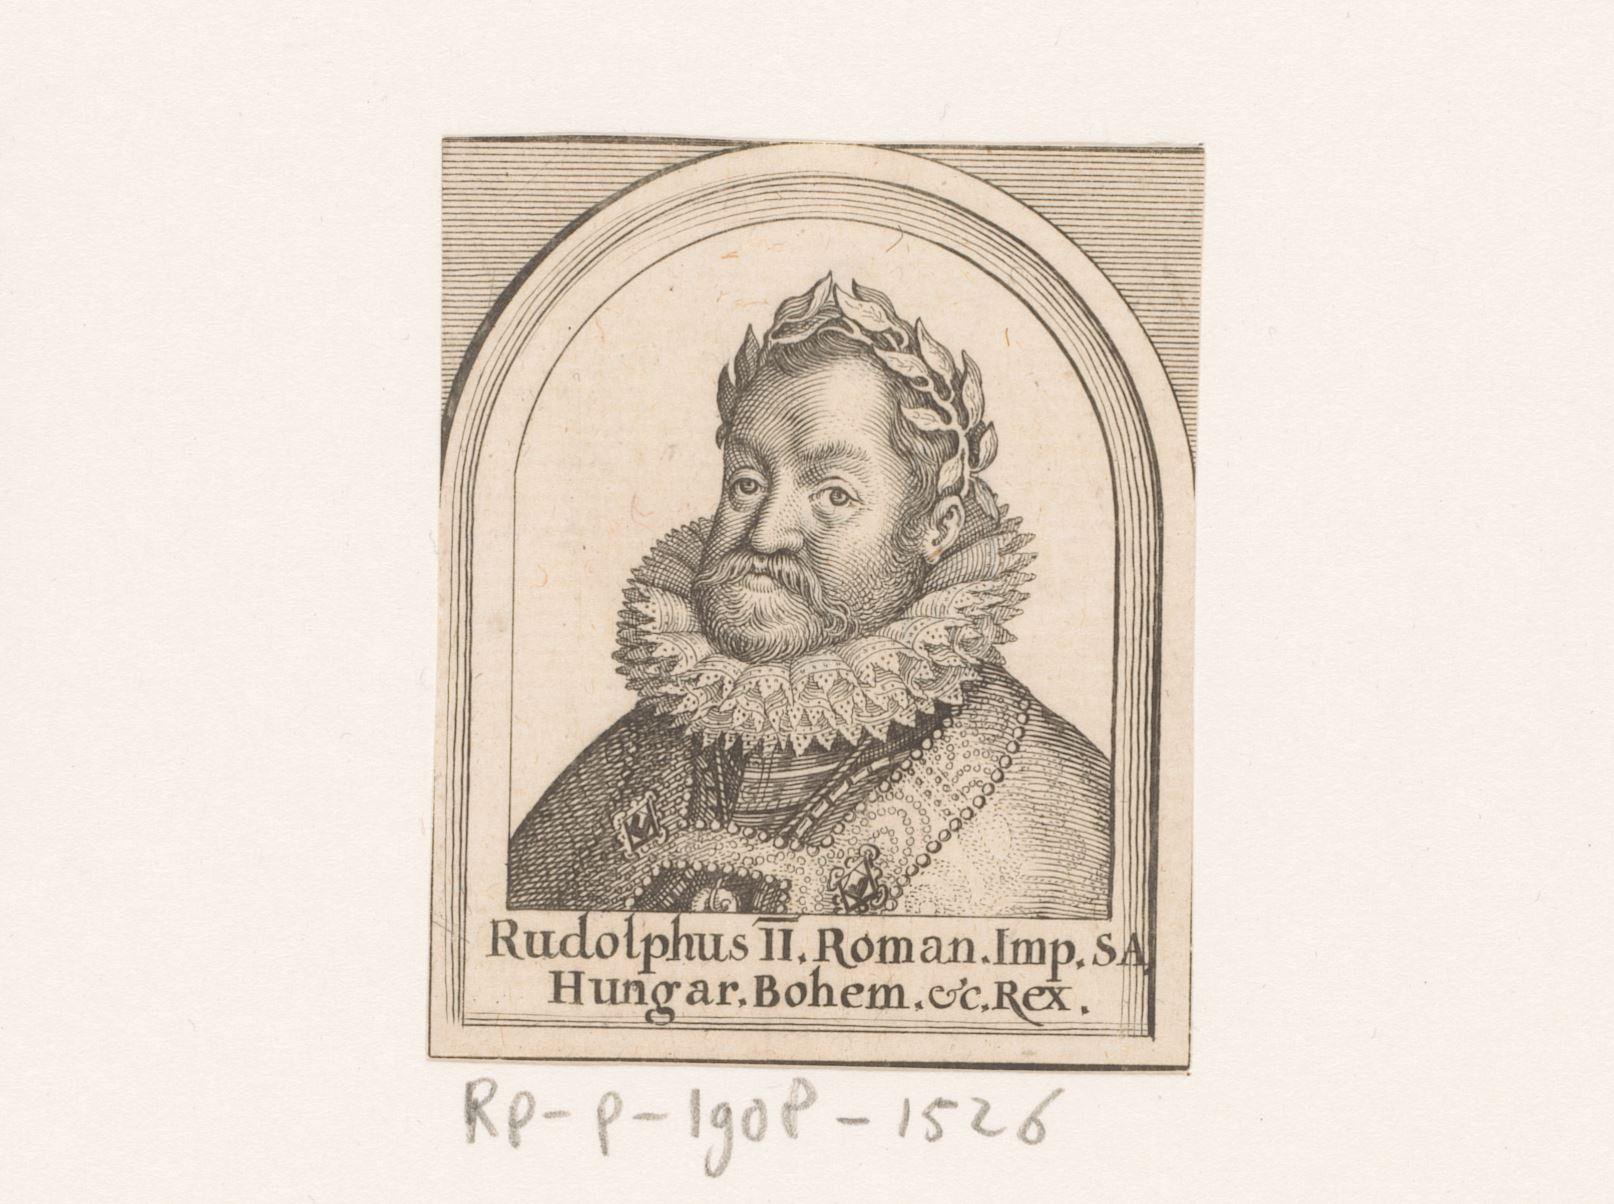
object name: print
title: Portret van keizer Rudolf II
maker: matthäus merian (i)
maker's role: print maker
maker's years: 1593-1650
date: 1603-1650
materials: paper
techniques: engraving, etching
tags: vienna, prague, rudolf ii van habsburg (duits keizer), garland, wreath, historical persons